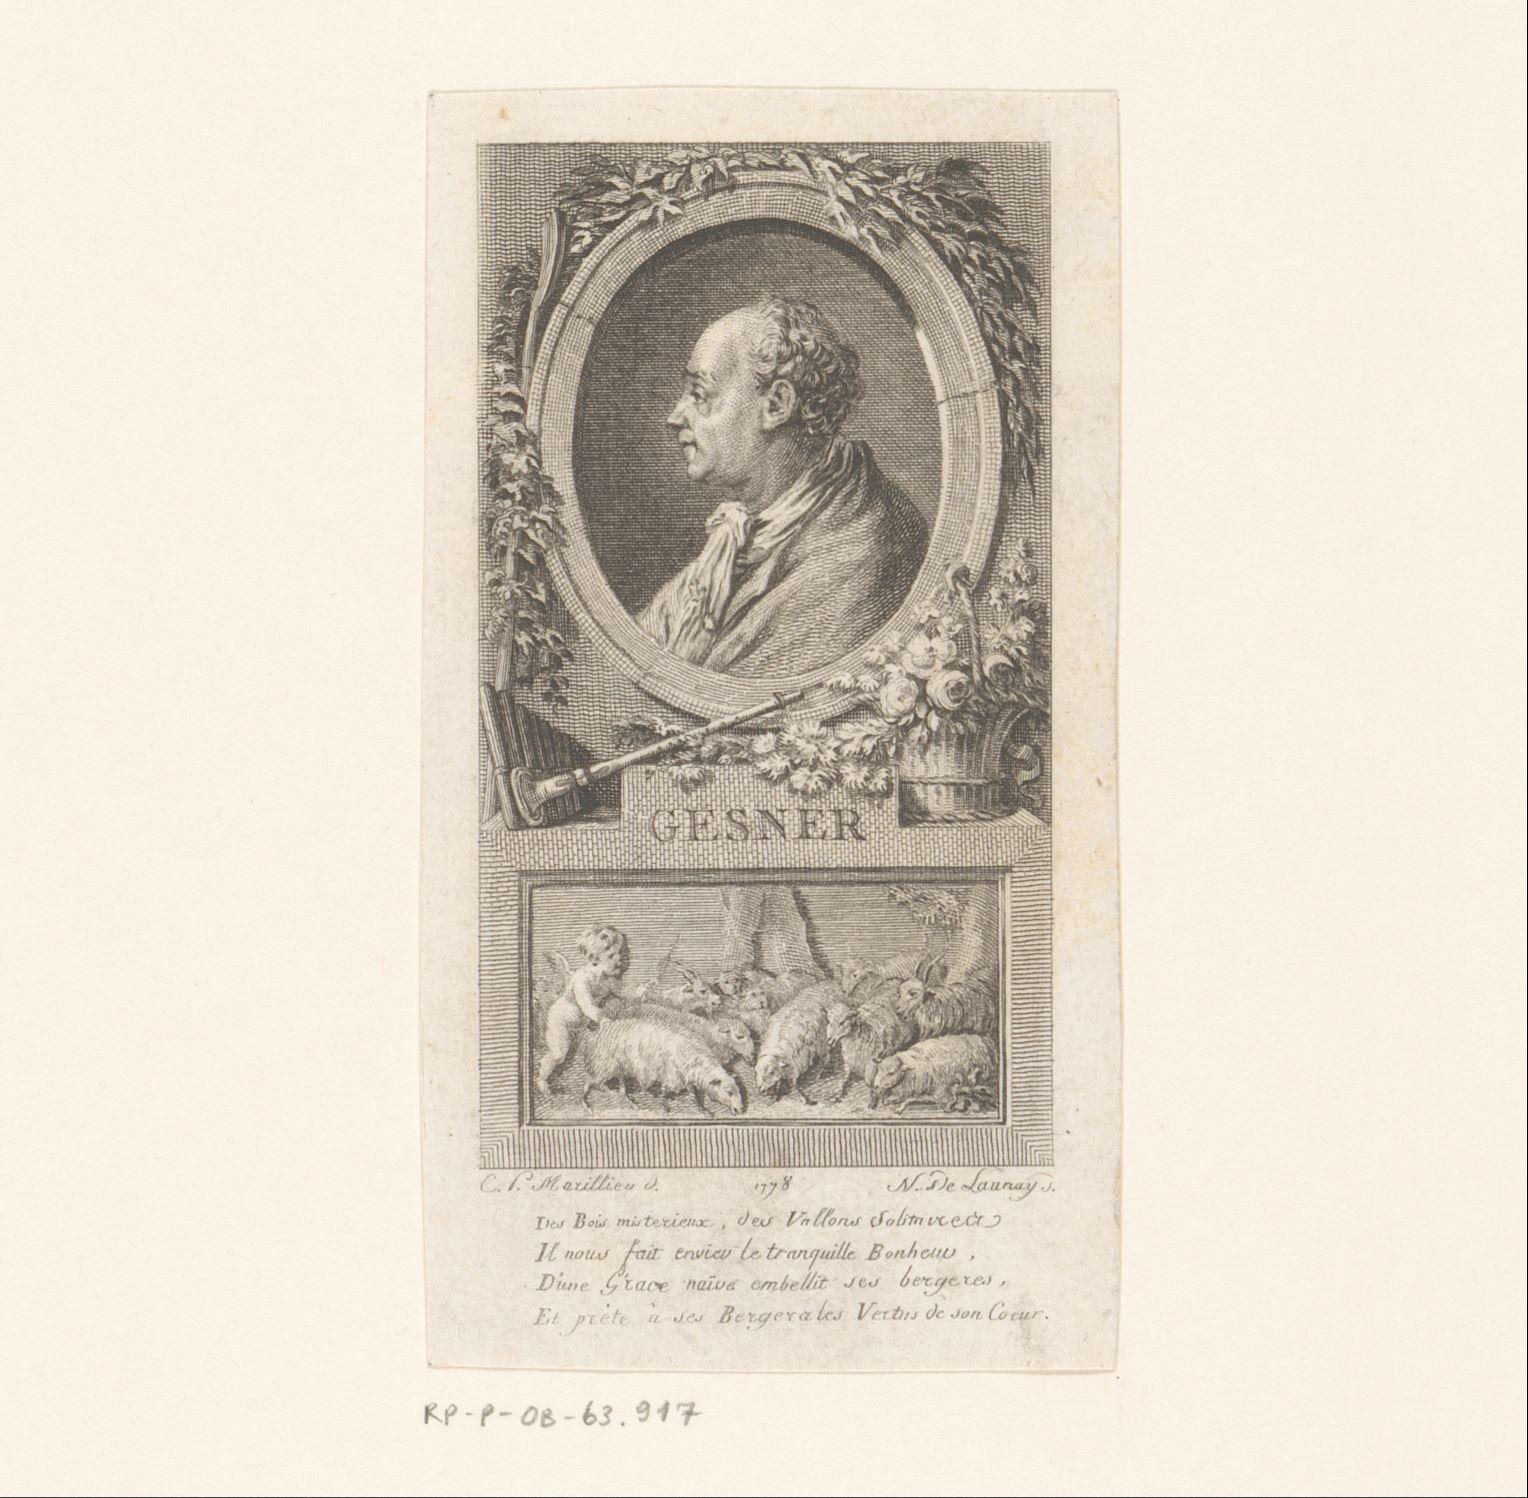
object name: book illustration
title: Gesner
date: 1778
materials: paper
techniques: etching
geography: france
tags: painter, salomon gessner, historical persons, portrait, self-portrait of painter, writer, poet, author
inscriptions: collector's mark: Lugt 2228